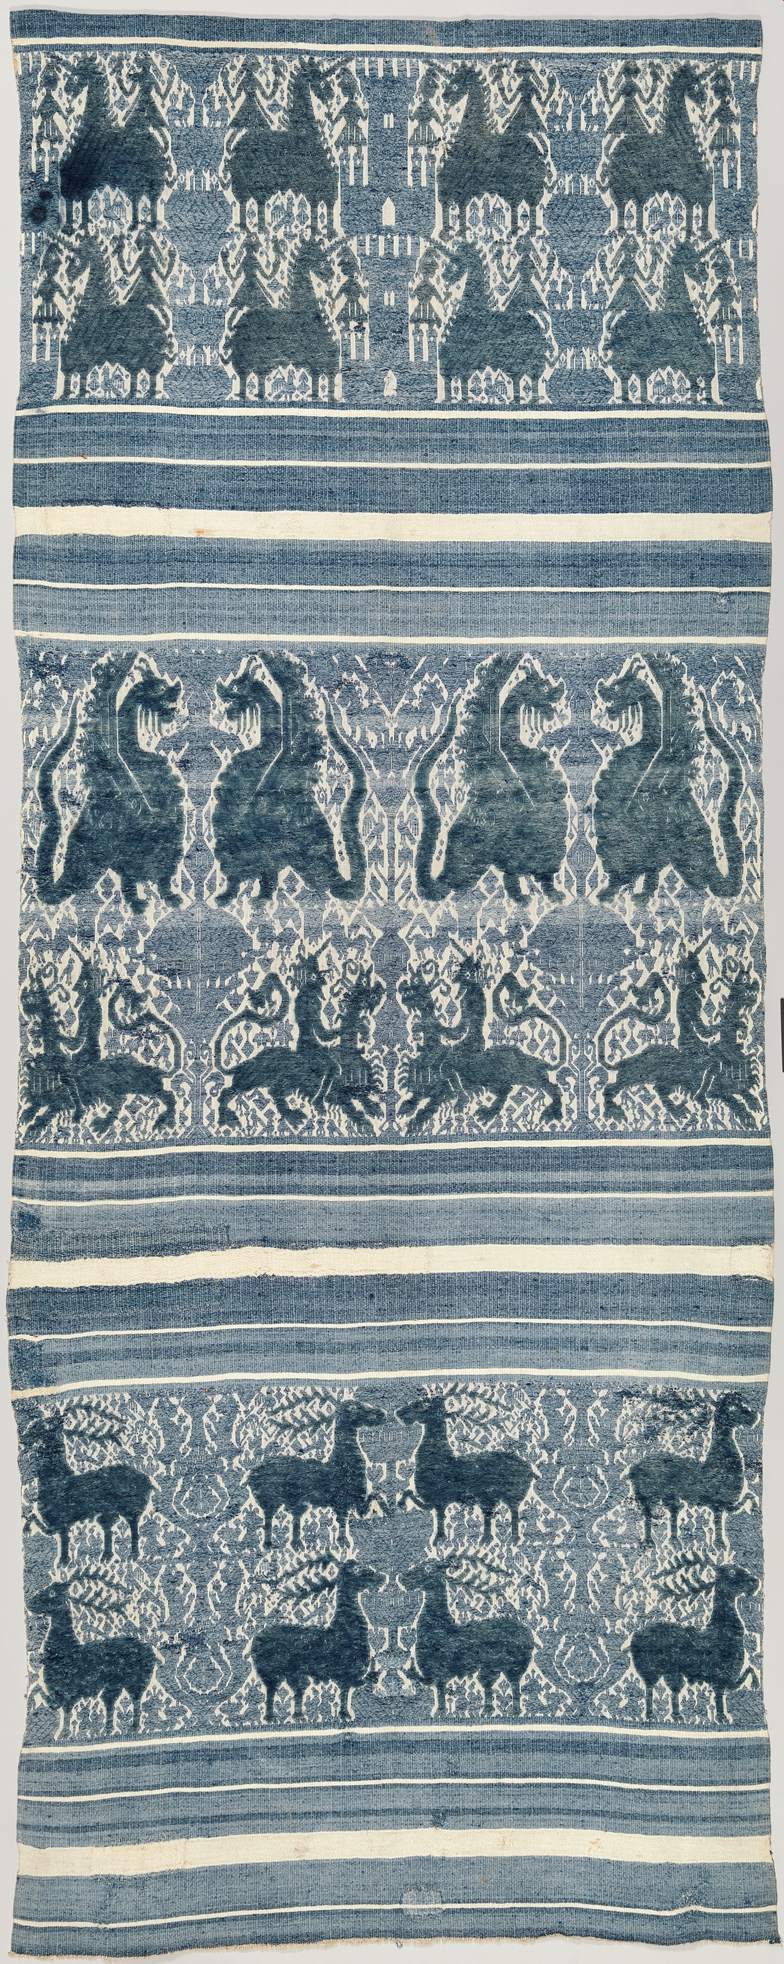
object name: cover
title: Cover with Unicorns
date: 1501-1600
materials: cotton, fiber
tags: centaurs,unicorns,deer